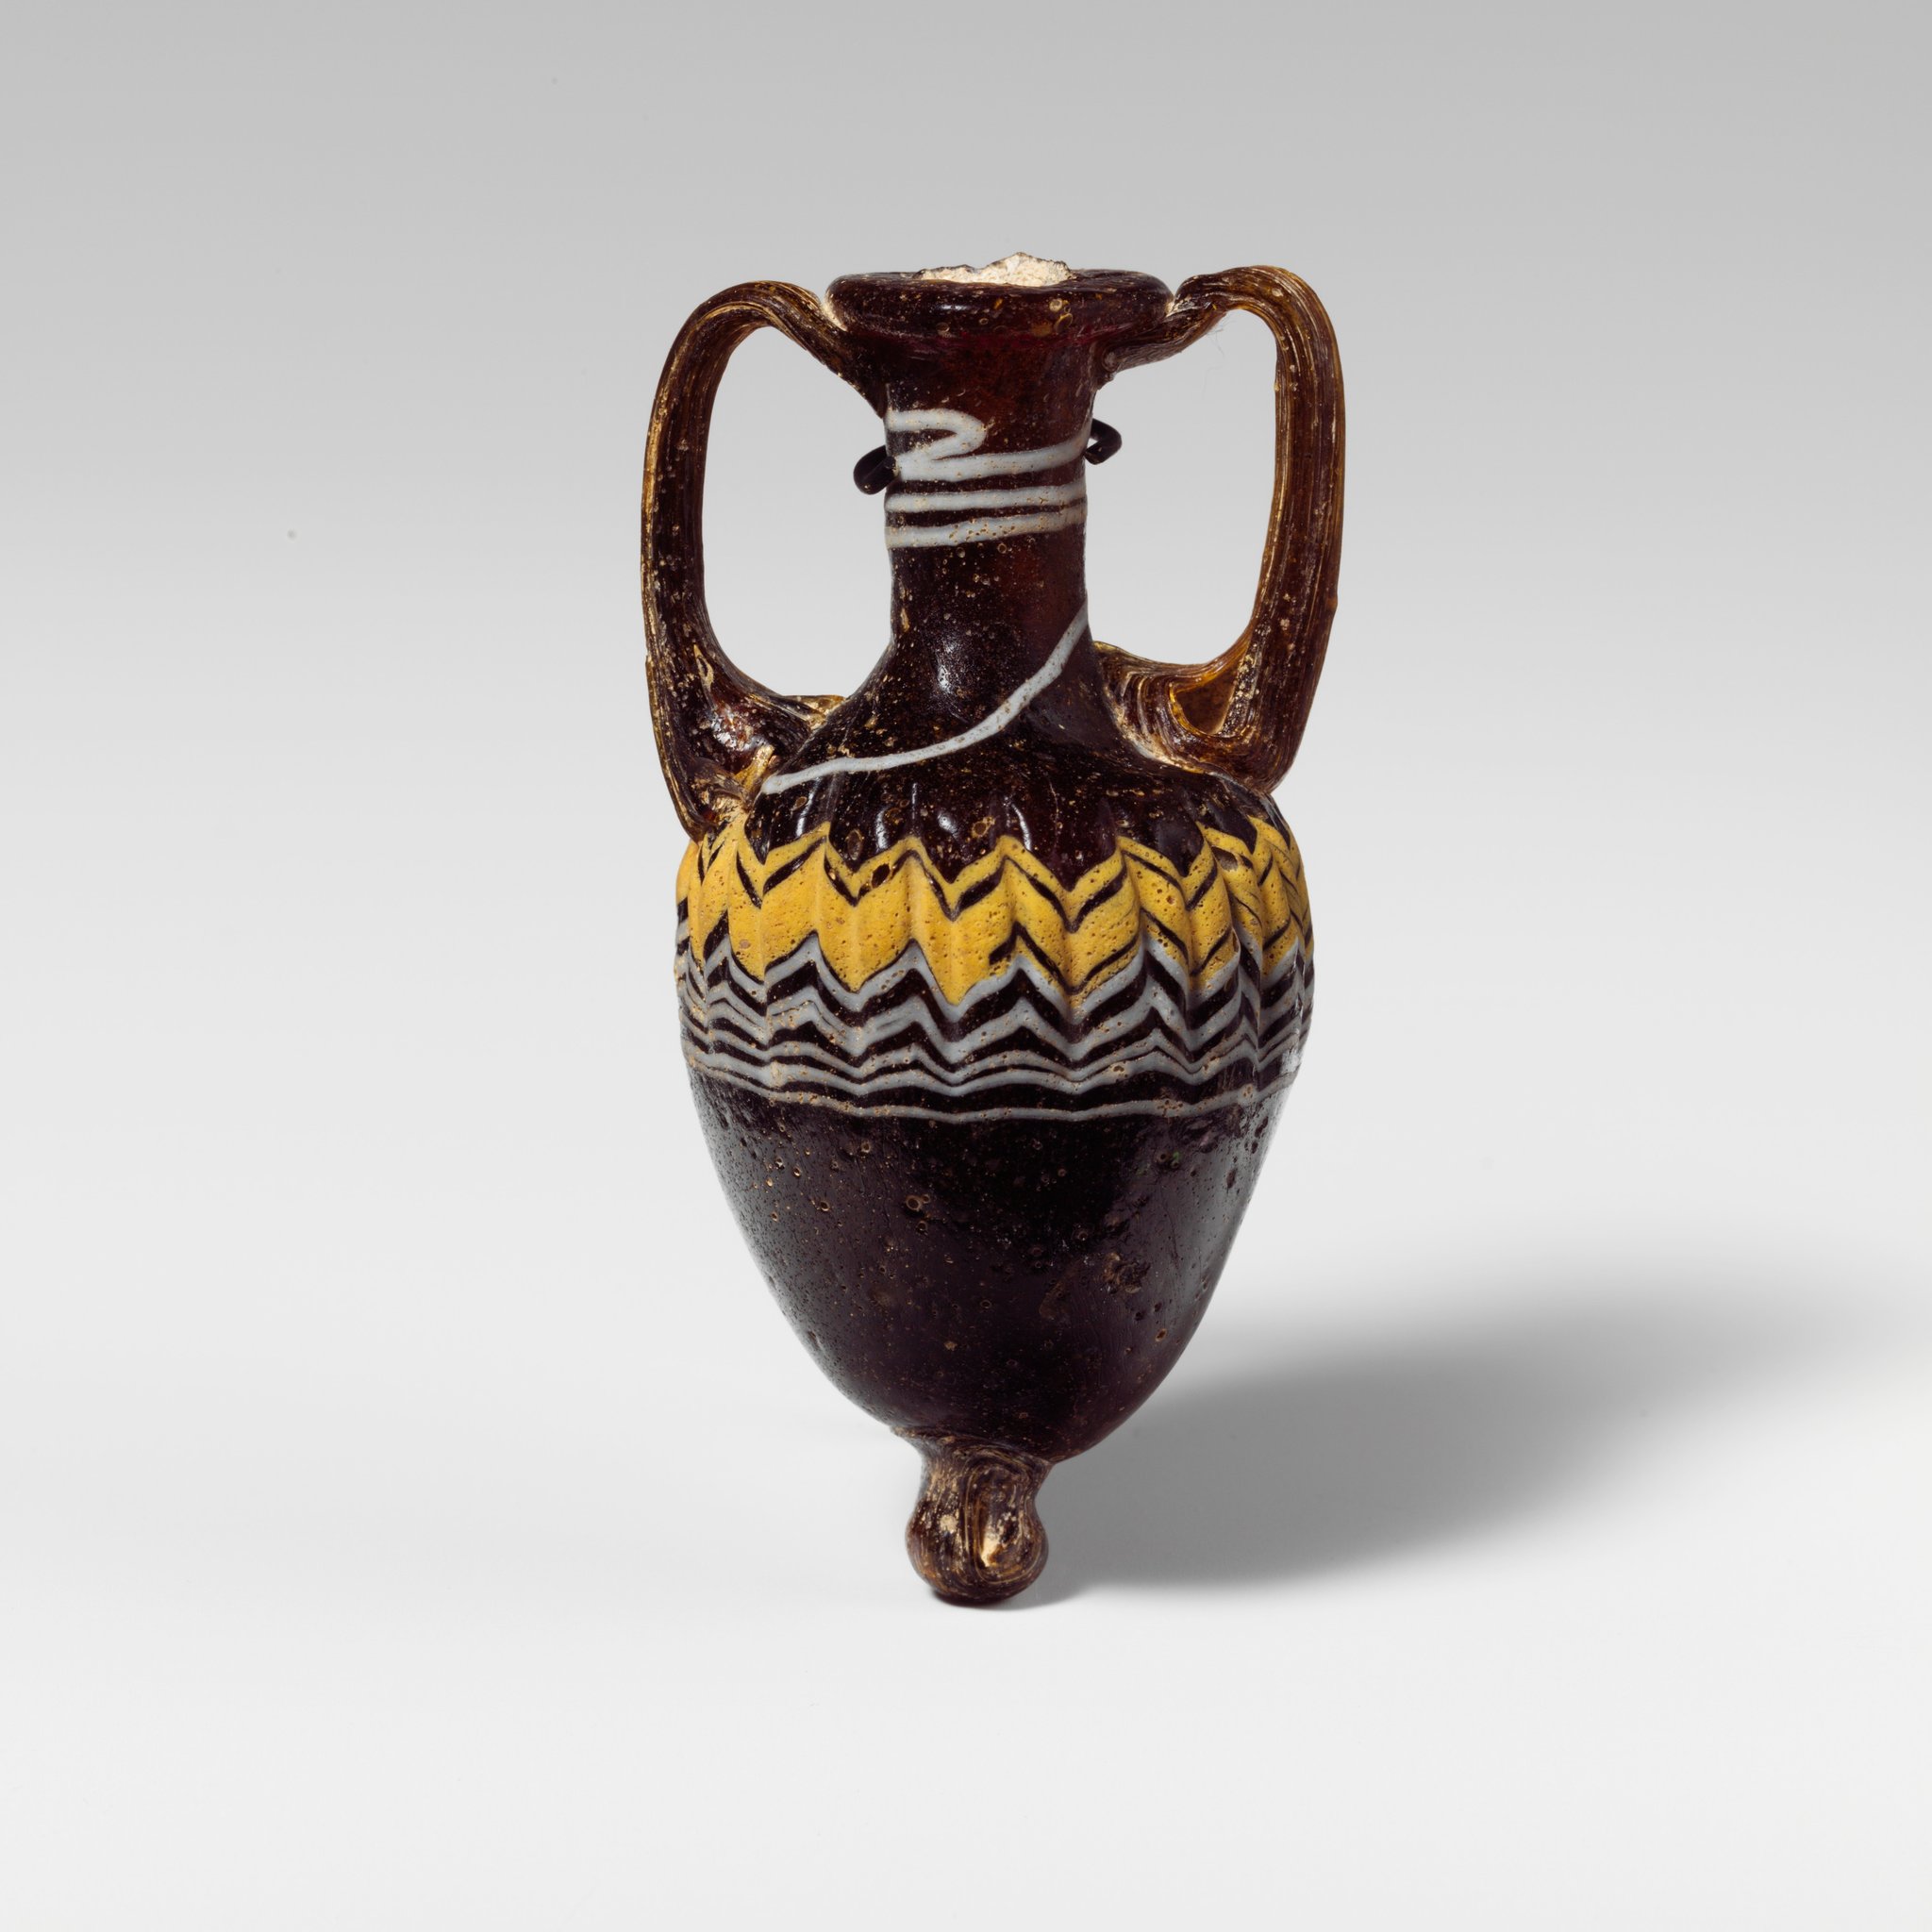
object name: amphoriskos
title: Glass amphoriskos (perfume bottle)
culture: greek, eastern mediterranean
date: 300-201 BCE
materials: glass